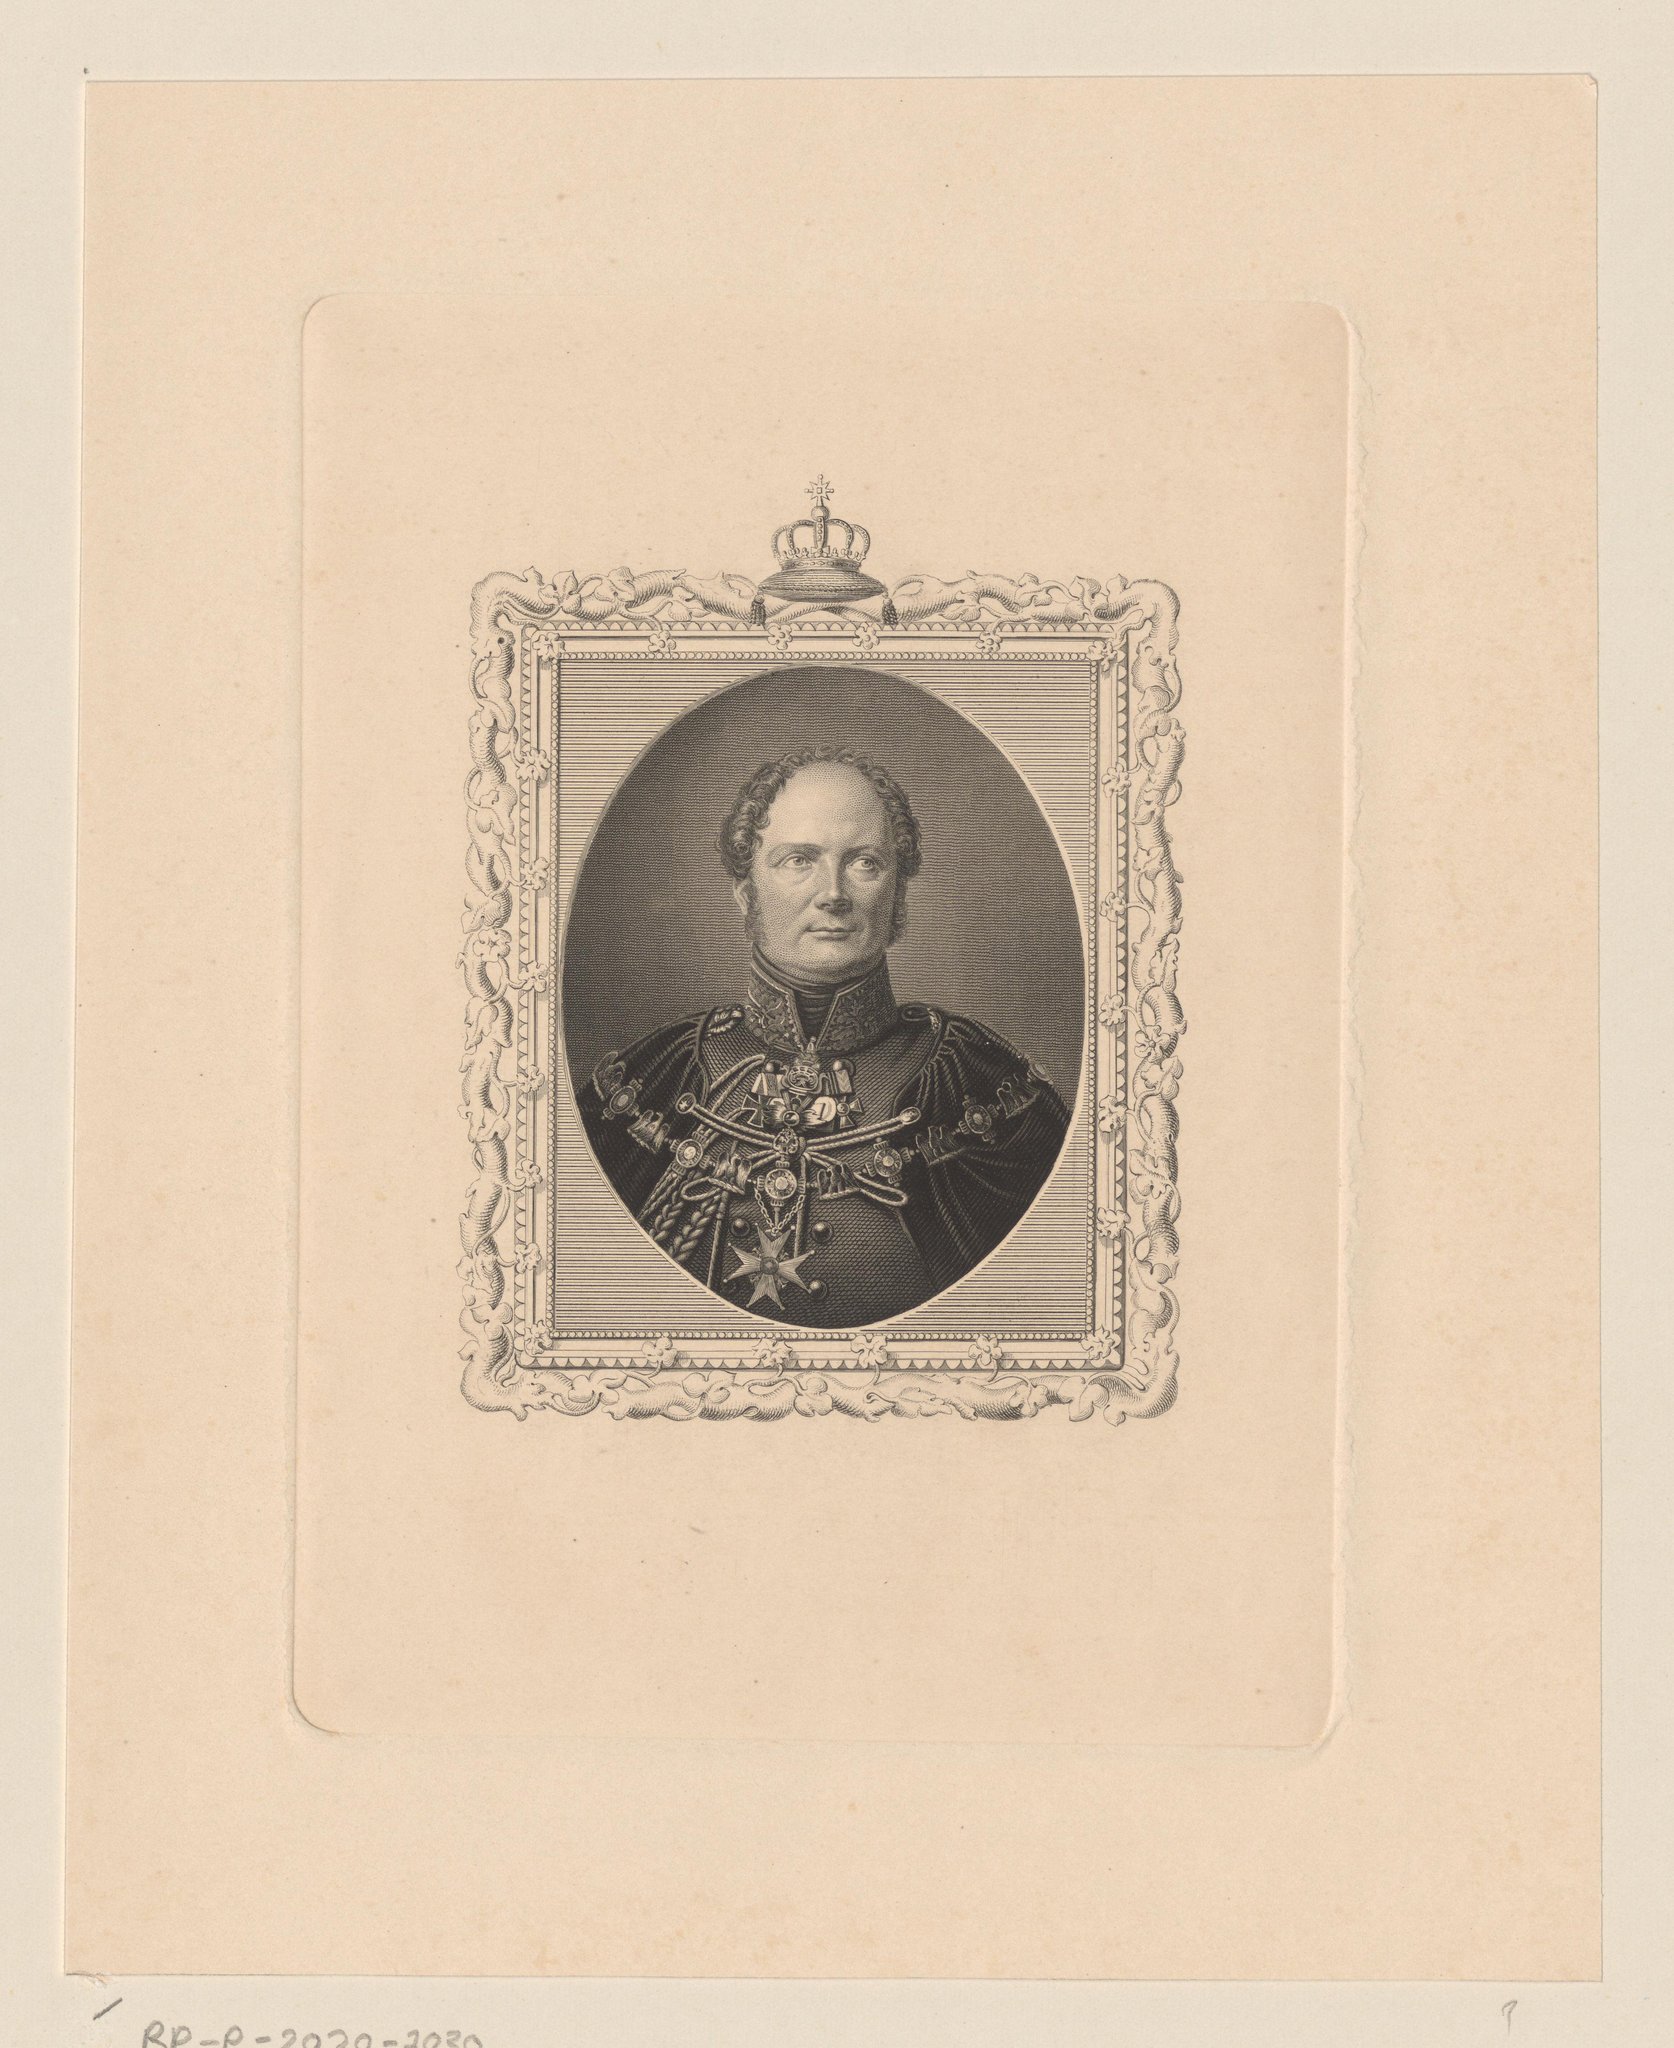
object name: print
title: Portret van Frederik Willem IV van Pruisen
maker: Anonymous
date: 1840-1899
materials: paper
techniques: etching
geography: germany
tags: berlin, frederik willem iv (koning van pruisen), crown (symbol of sovereignty), knighthood order (with name) - insignia of a knighthood order, e.g.: badge, chain (with name of order), historical persons, (military) uniforms, king